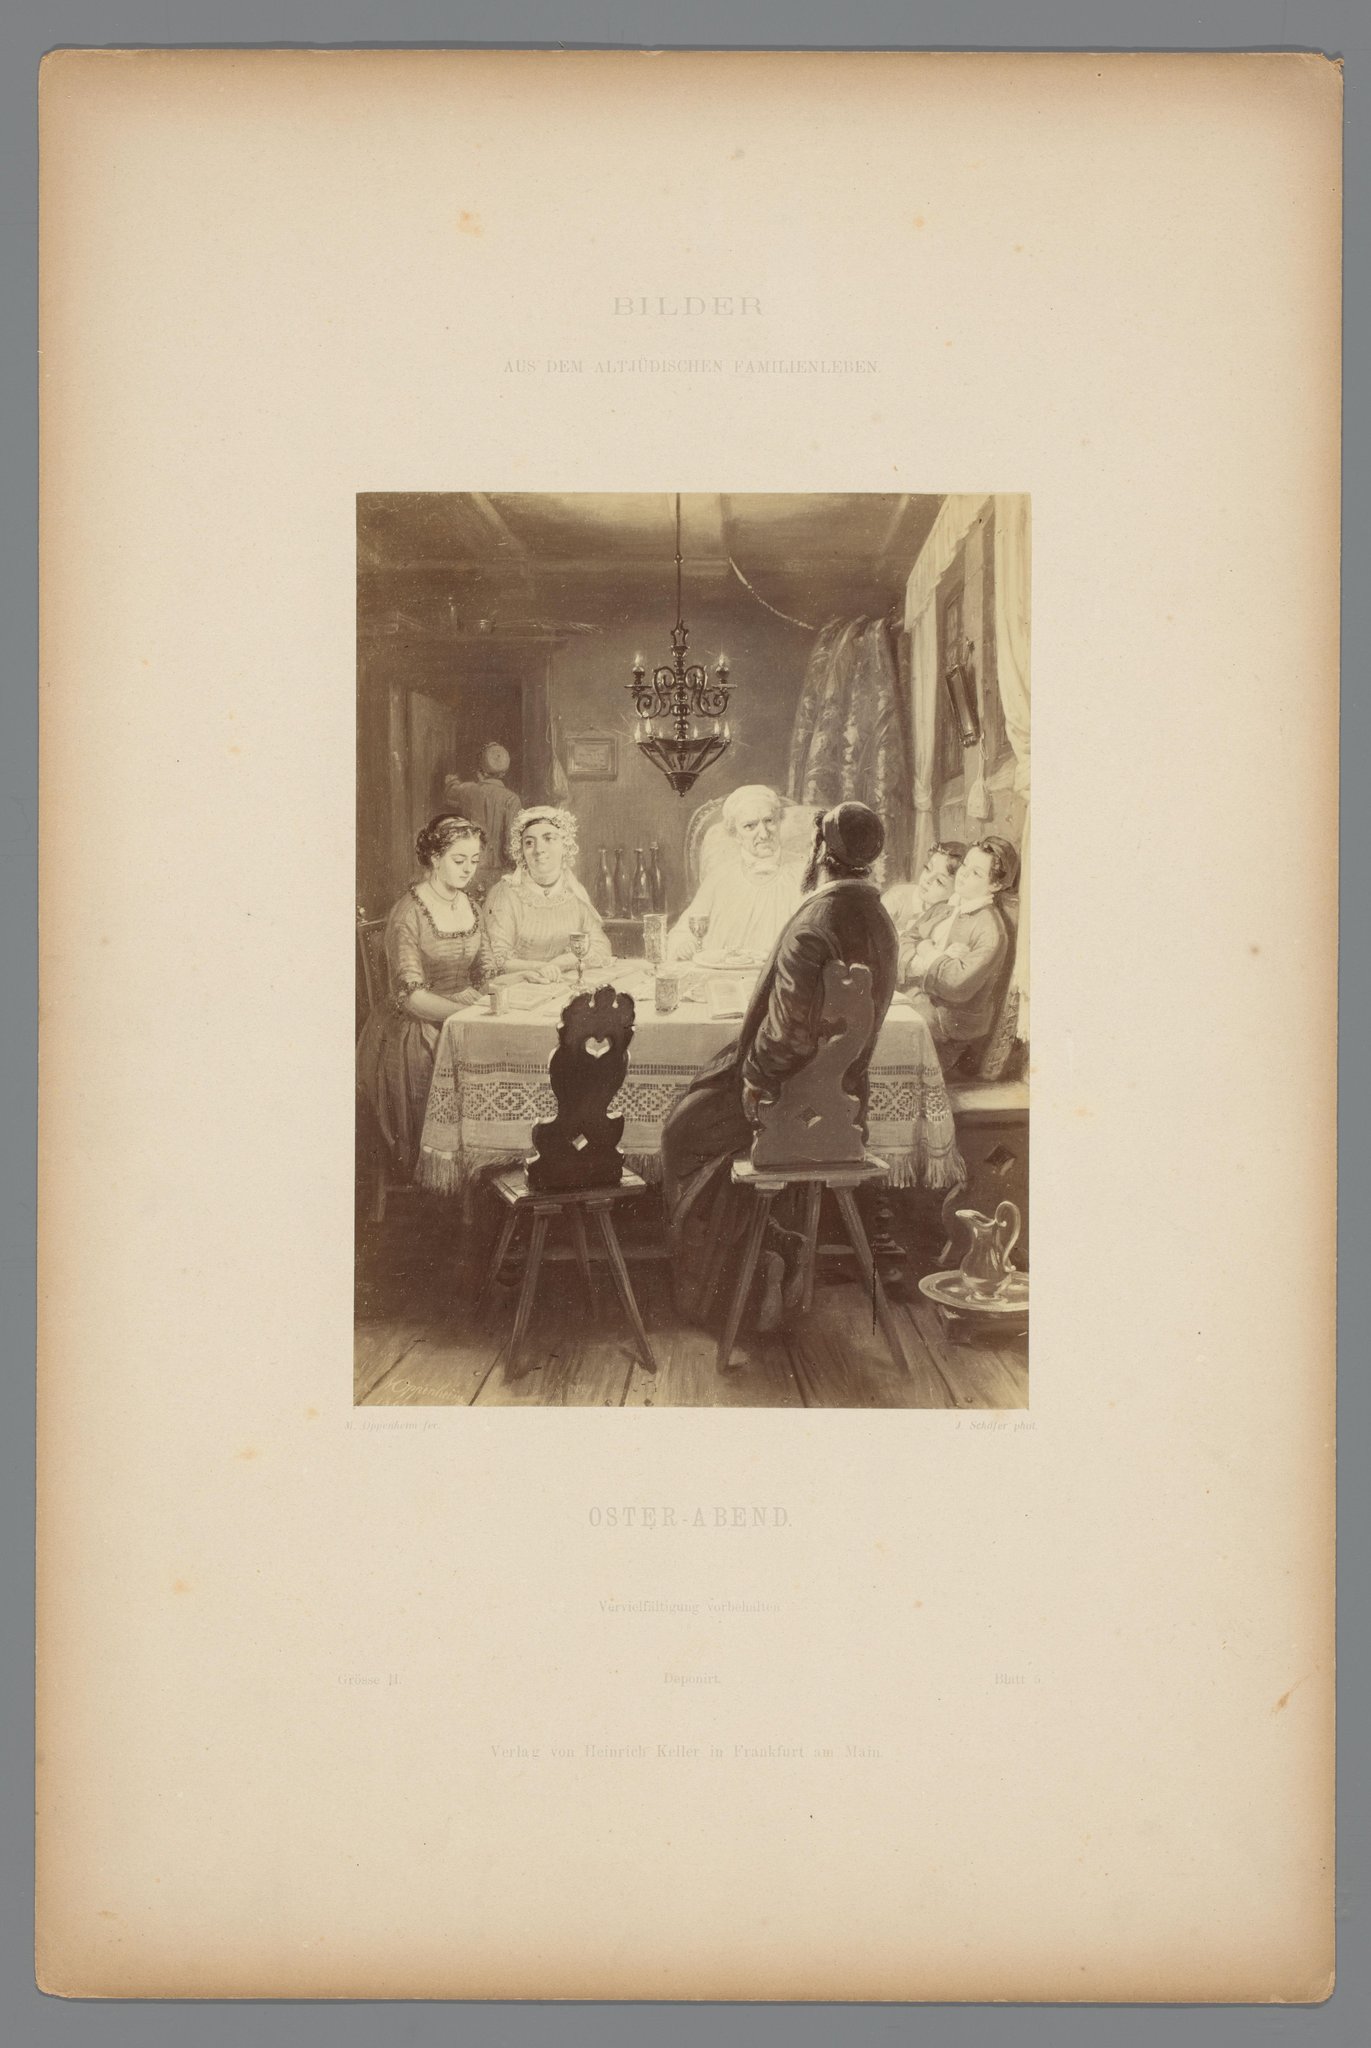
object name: photograph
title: Bilder aus dem Altjüdischen Familienleben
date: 1866-1900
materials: cardboard, photographic support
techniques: albumen print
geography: frankfurt am main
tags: 'seder' (home service for 'pesah')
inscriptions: inscription: ‘Vervielfältigung vorbehalten./ Grösse II - Deponirt - Blatt 5.’